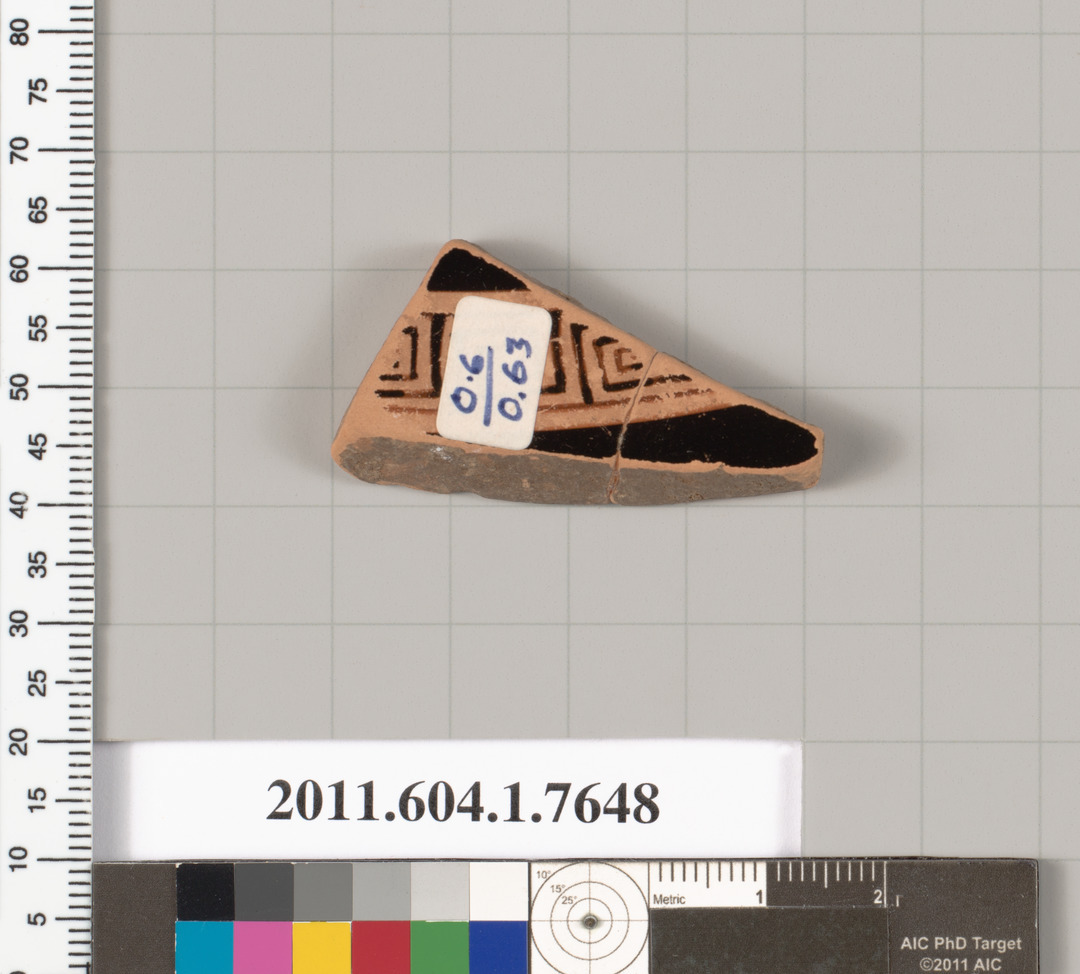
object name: kylix fragment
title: Terracotta fragment of a kylix (drinking cup)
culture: greek, attic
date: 460-450 BCE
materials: terracotta